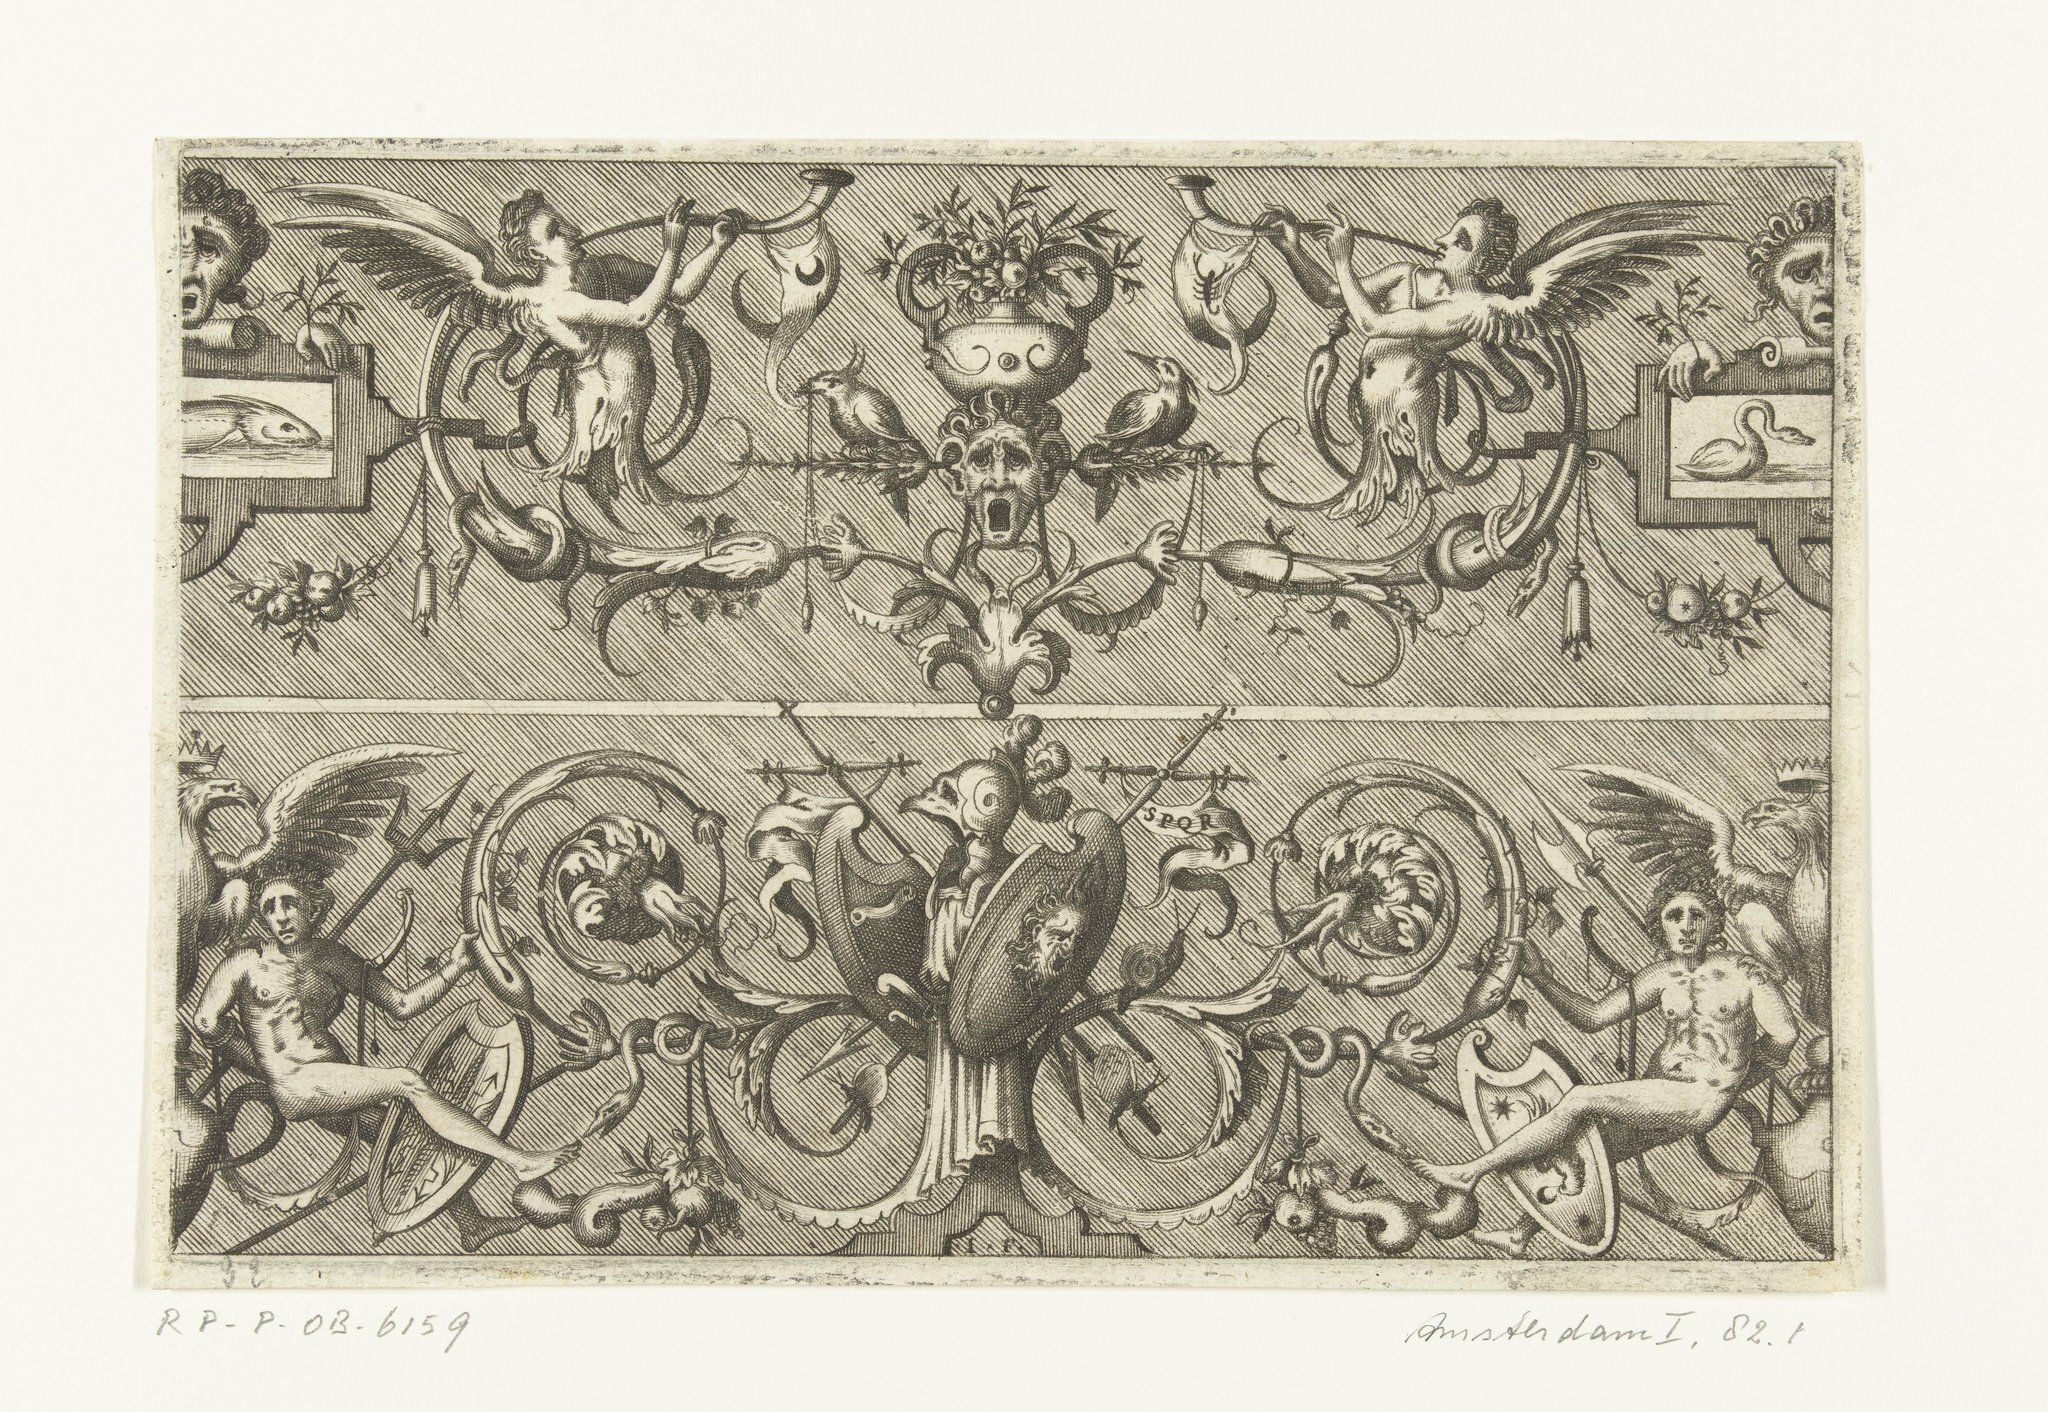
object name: print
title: Compertimenta pictoriis flosculis manubiisque…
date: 1567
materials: paper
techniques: engraving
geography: netherlands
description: In het midden van het bovenste fries bevindt zich een mascaron, geflankeerd door twee gevleugelde halffiguren met bazuinen. Het onderste fries bestaat uit een wapentrofee geflankeerd door twee zittende krijgers. Gearceerde achtergrond. Hoort bij serie van 14 bladen cartouches met rolwerk, grotesken, trofeeën en friezen. Het titelblad ontbreekt.